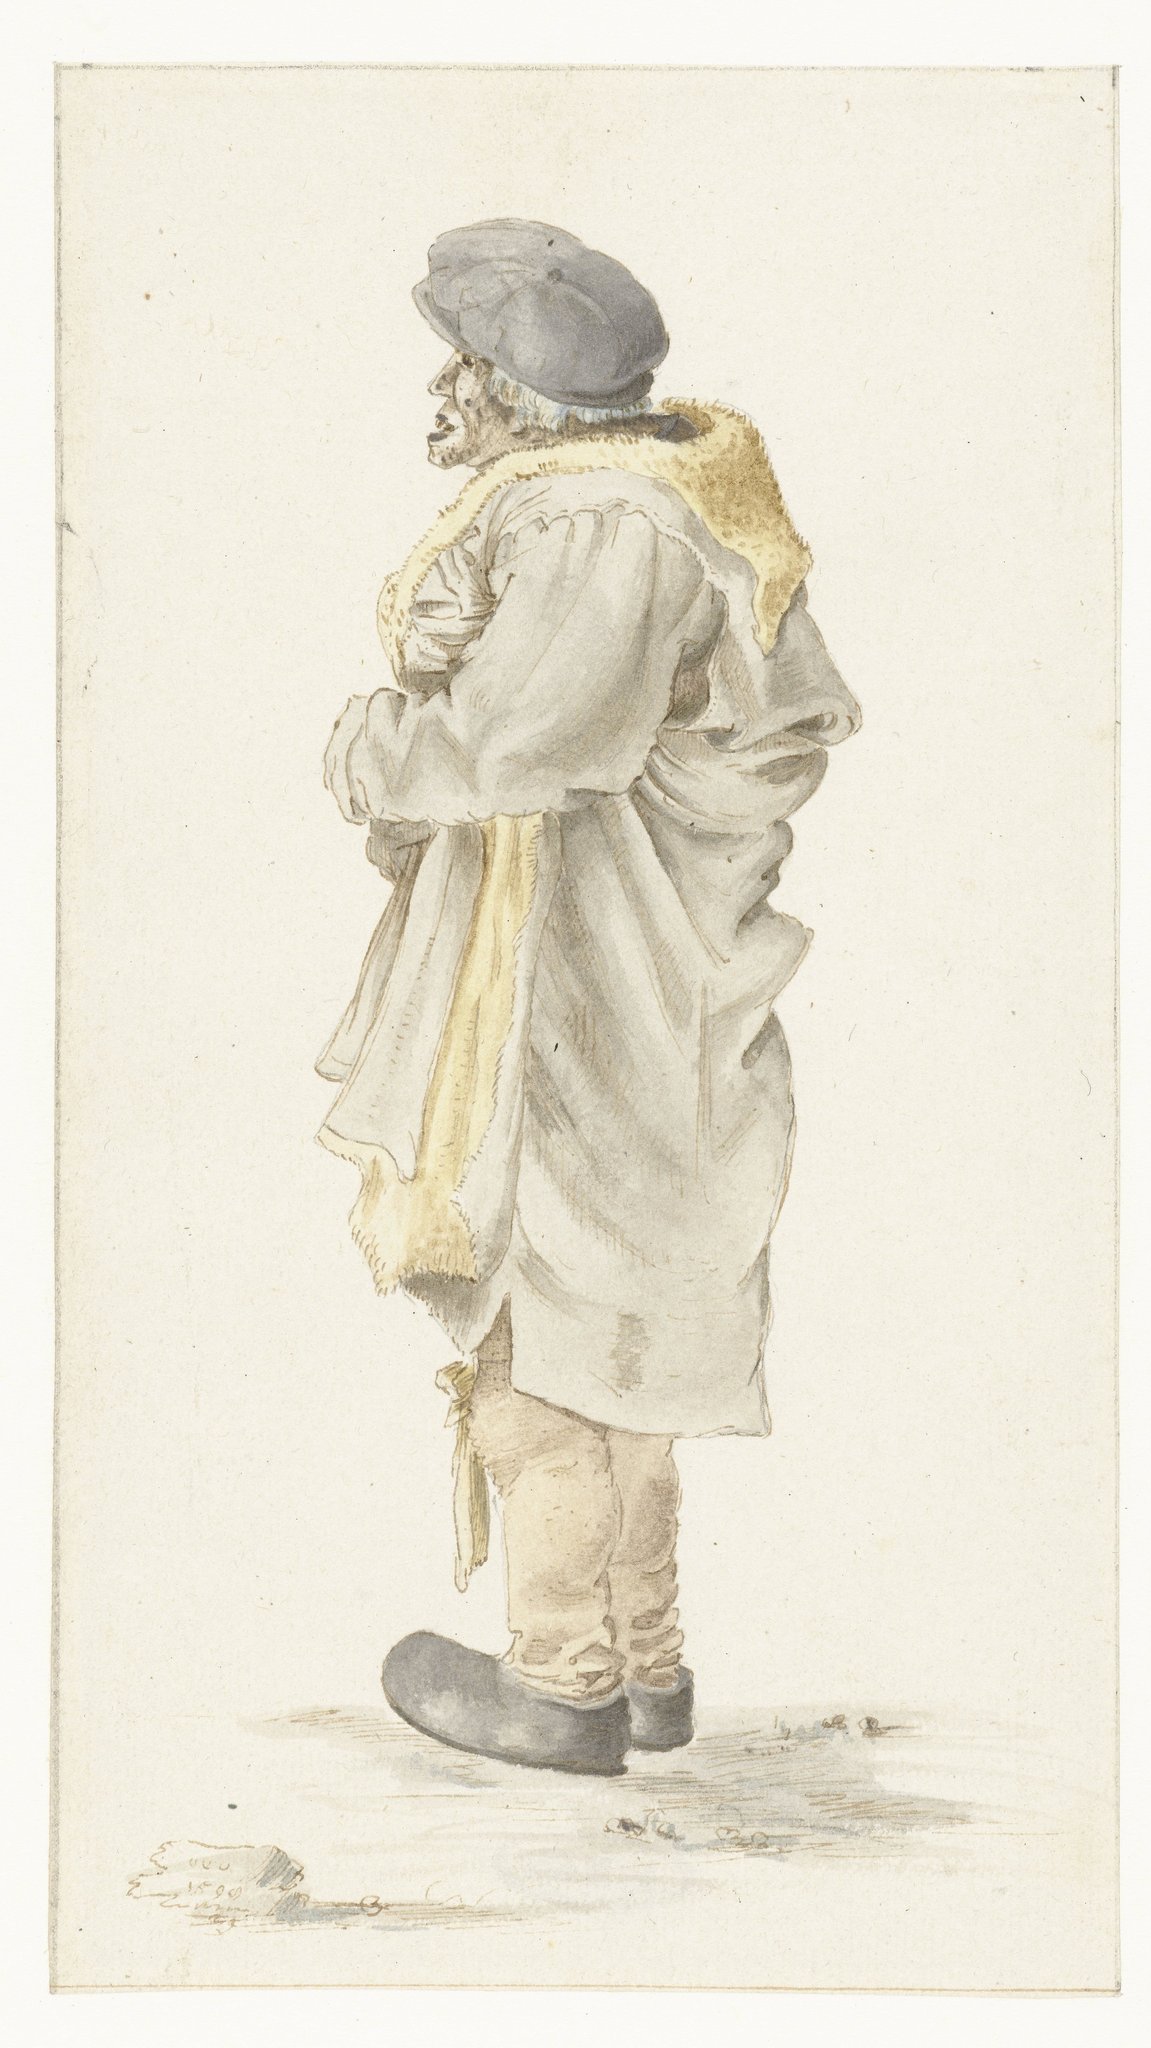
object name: drawing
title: Staande man in een met bont gevoerde jas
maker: Anonymous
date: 1613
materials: graphite, ink, paper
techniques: brush, pen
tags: standing figure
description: Staande man, in profiel naar links, gekleed in een met bont gevoerde jas.